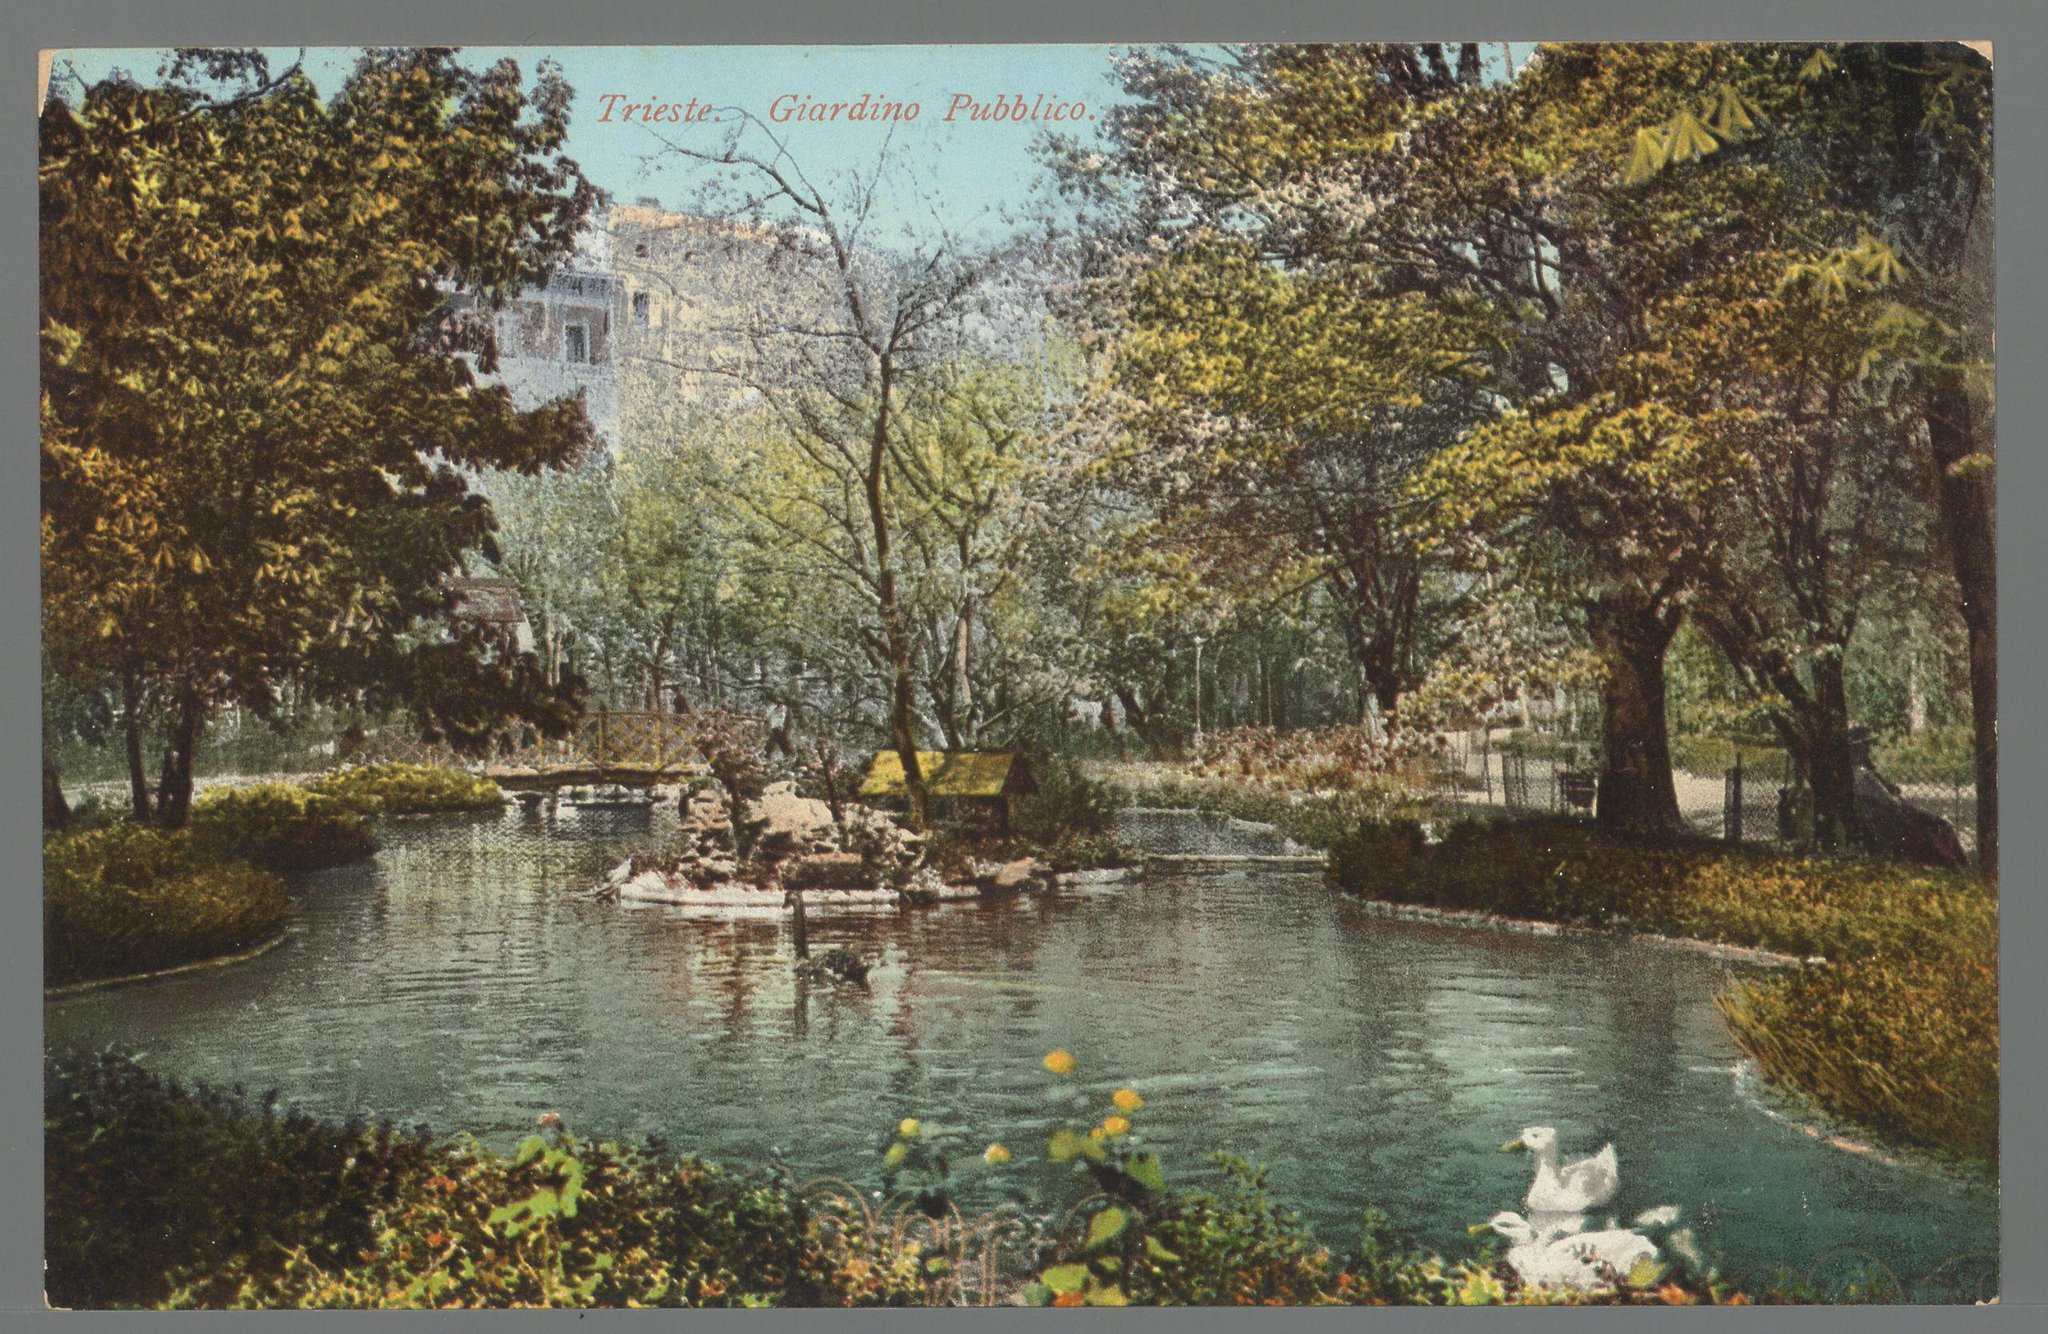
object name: photomechanical print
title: Trieste. Giardino Pubblico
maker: Anonymous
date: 1906-1909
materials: cardboard, photographic process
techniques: writing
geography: trieste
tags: city-view, and landscape with man-made constructions, trees, public gardens, park